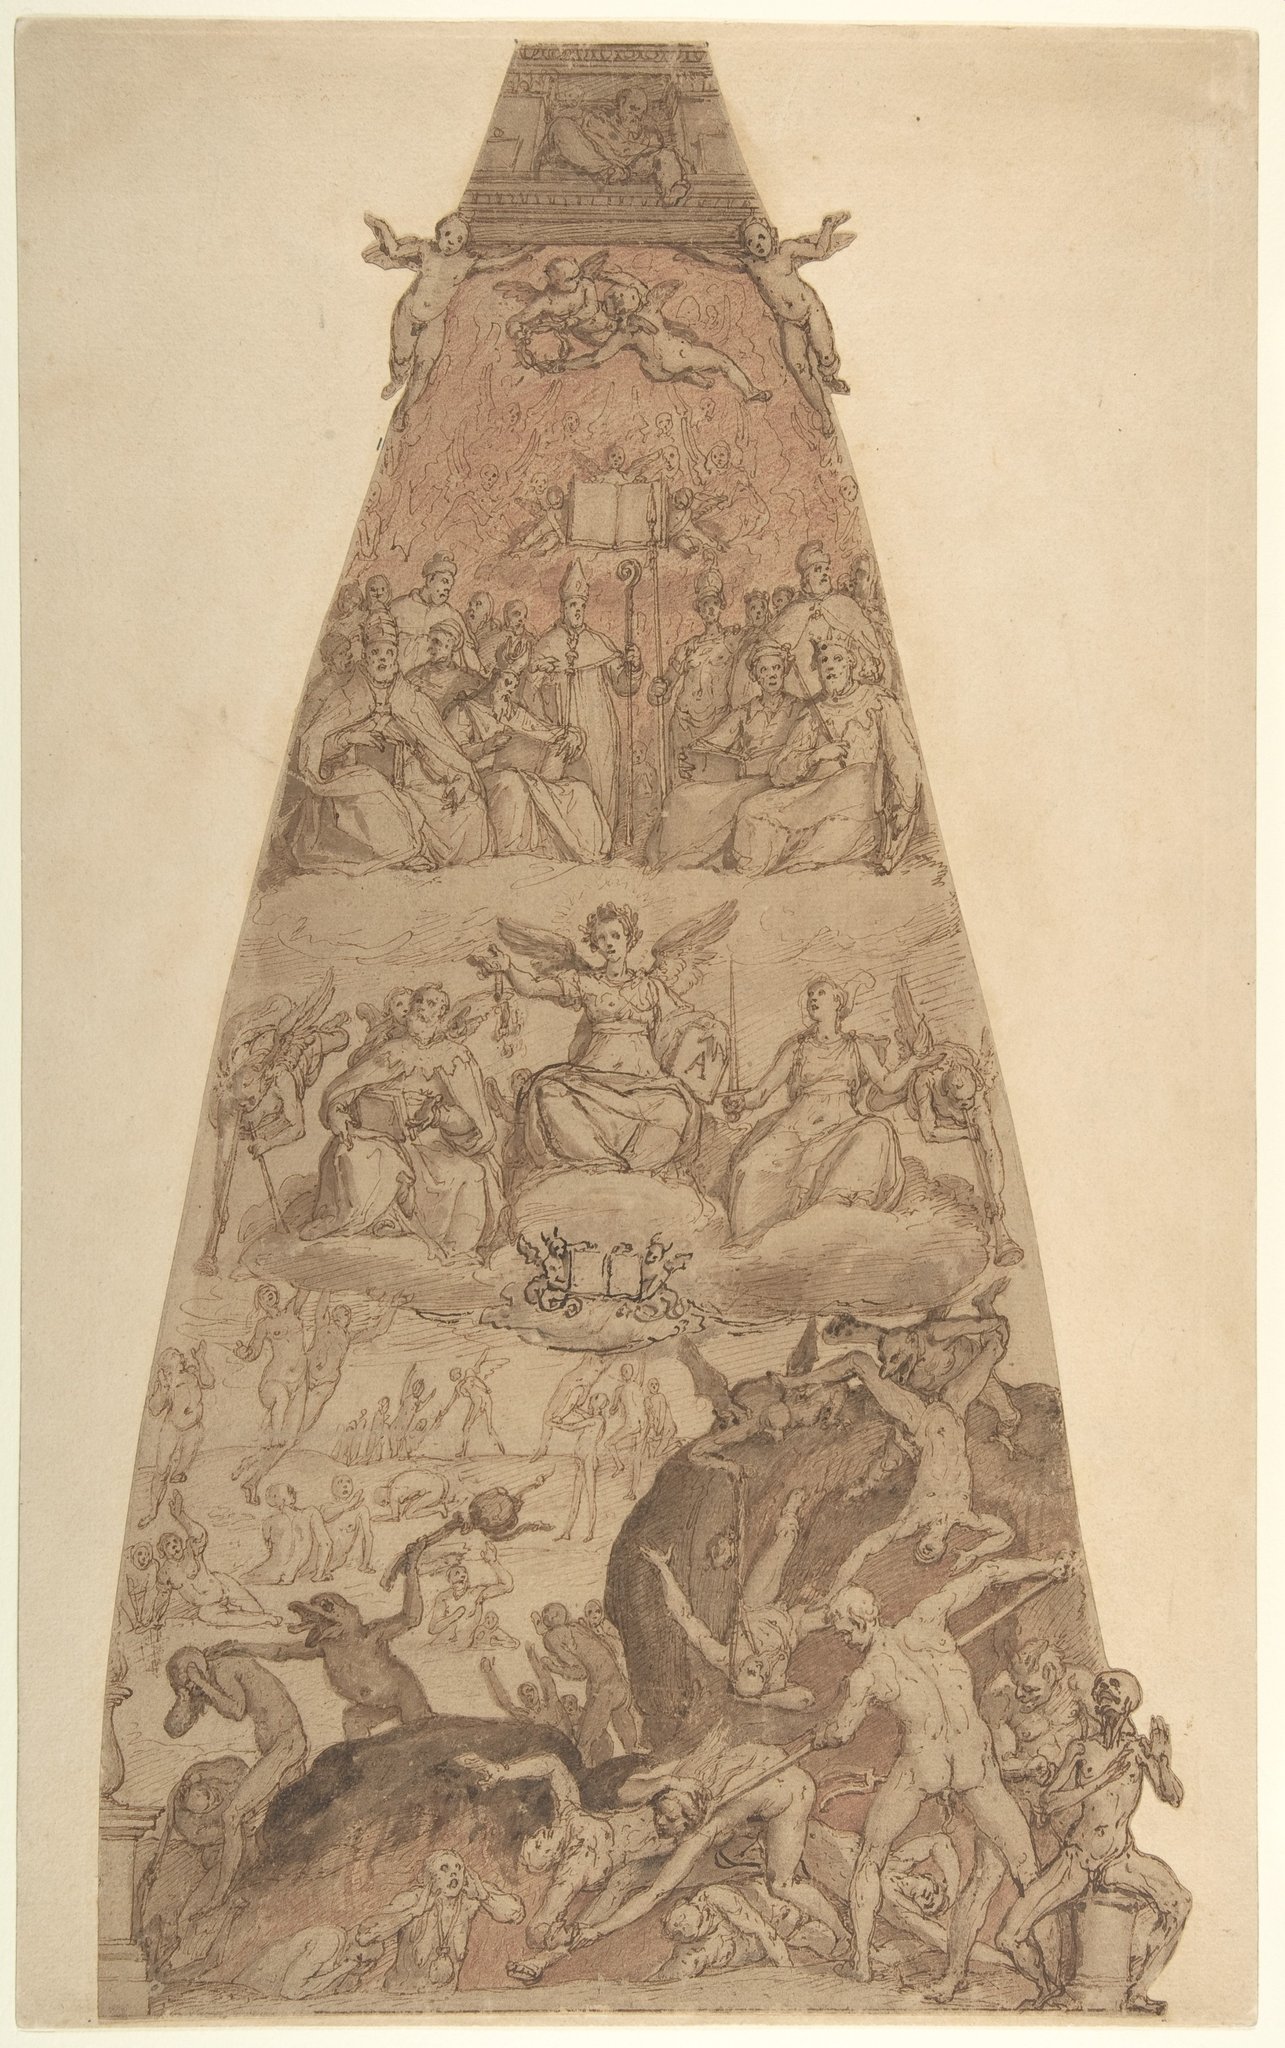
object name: drawing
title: Scene from the Last Judgment, Study for the Fresco Decoration of One of the Segments of the Cupola of the Cathedral of Santa Maria del Fiore in Florence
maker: federico zuccaro (zuccari)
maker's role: artist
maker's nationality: italian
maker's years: 1540-1609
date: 1576-1579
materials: chalk, ink, paper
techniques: brush, cutting, pen, wash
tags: men,male nudes,cupid